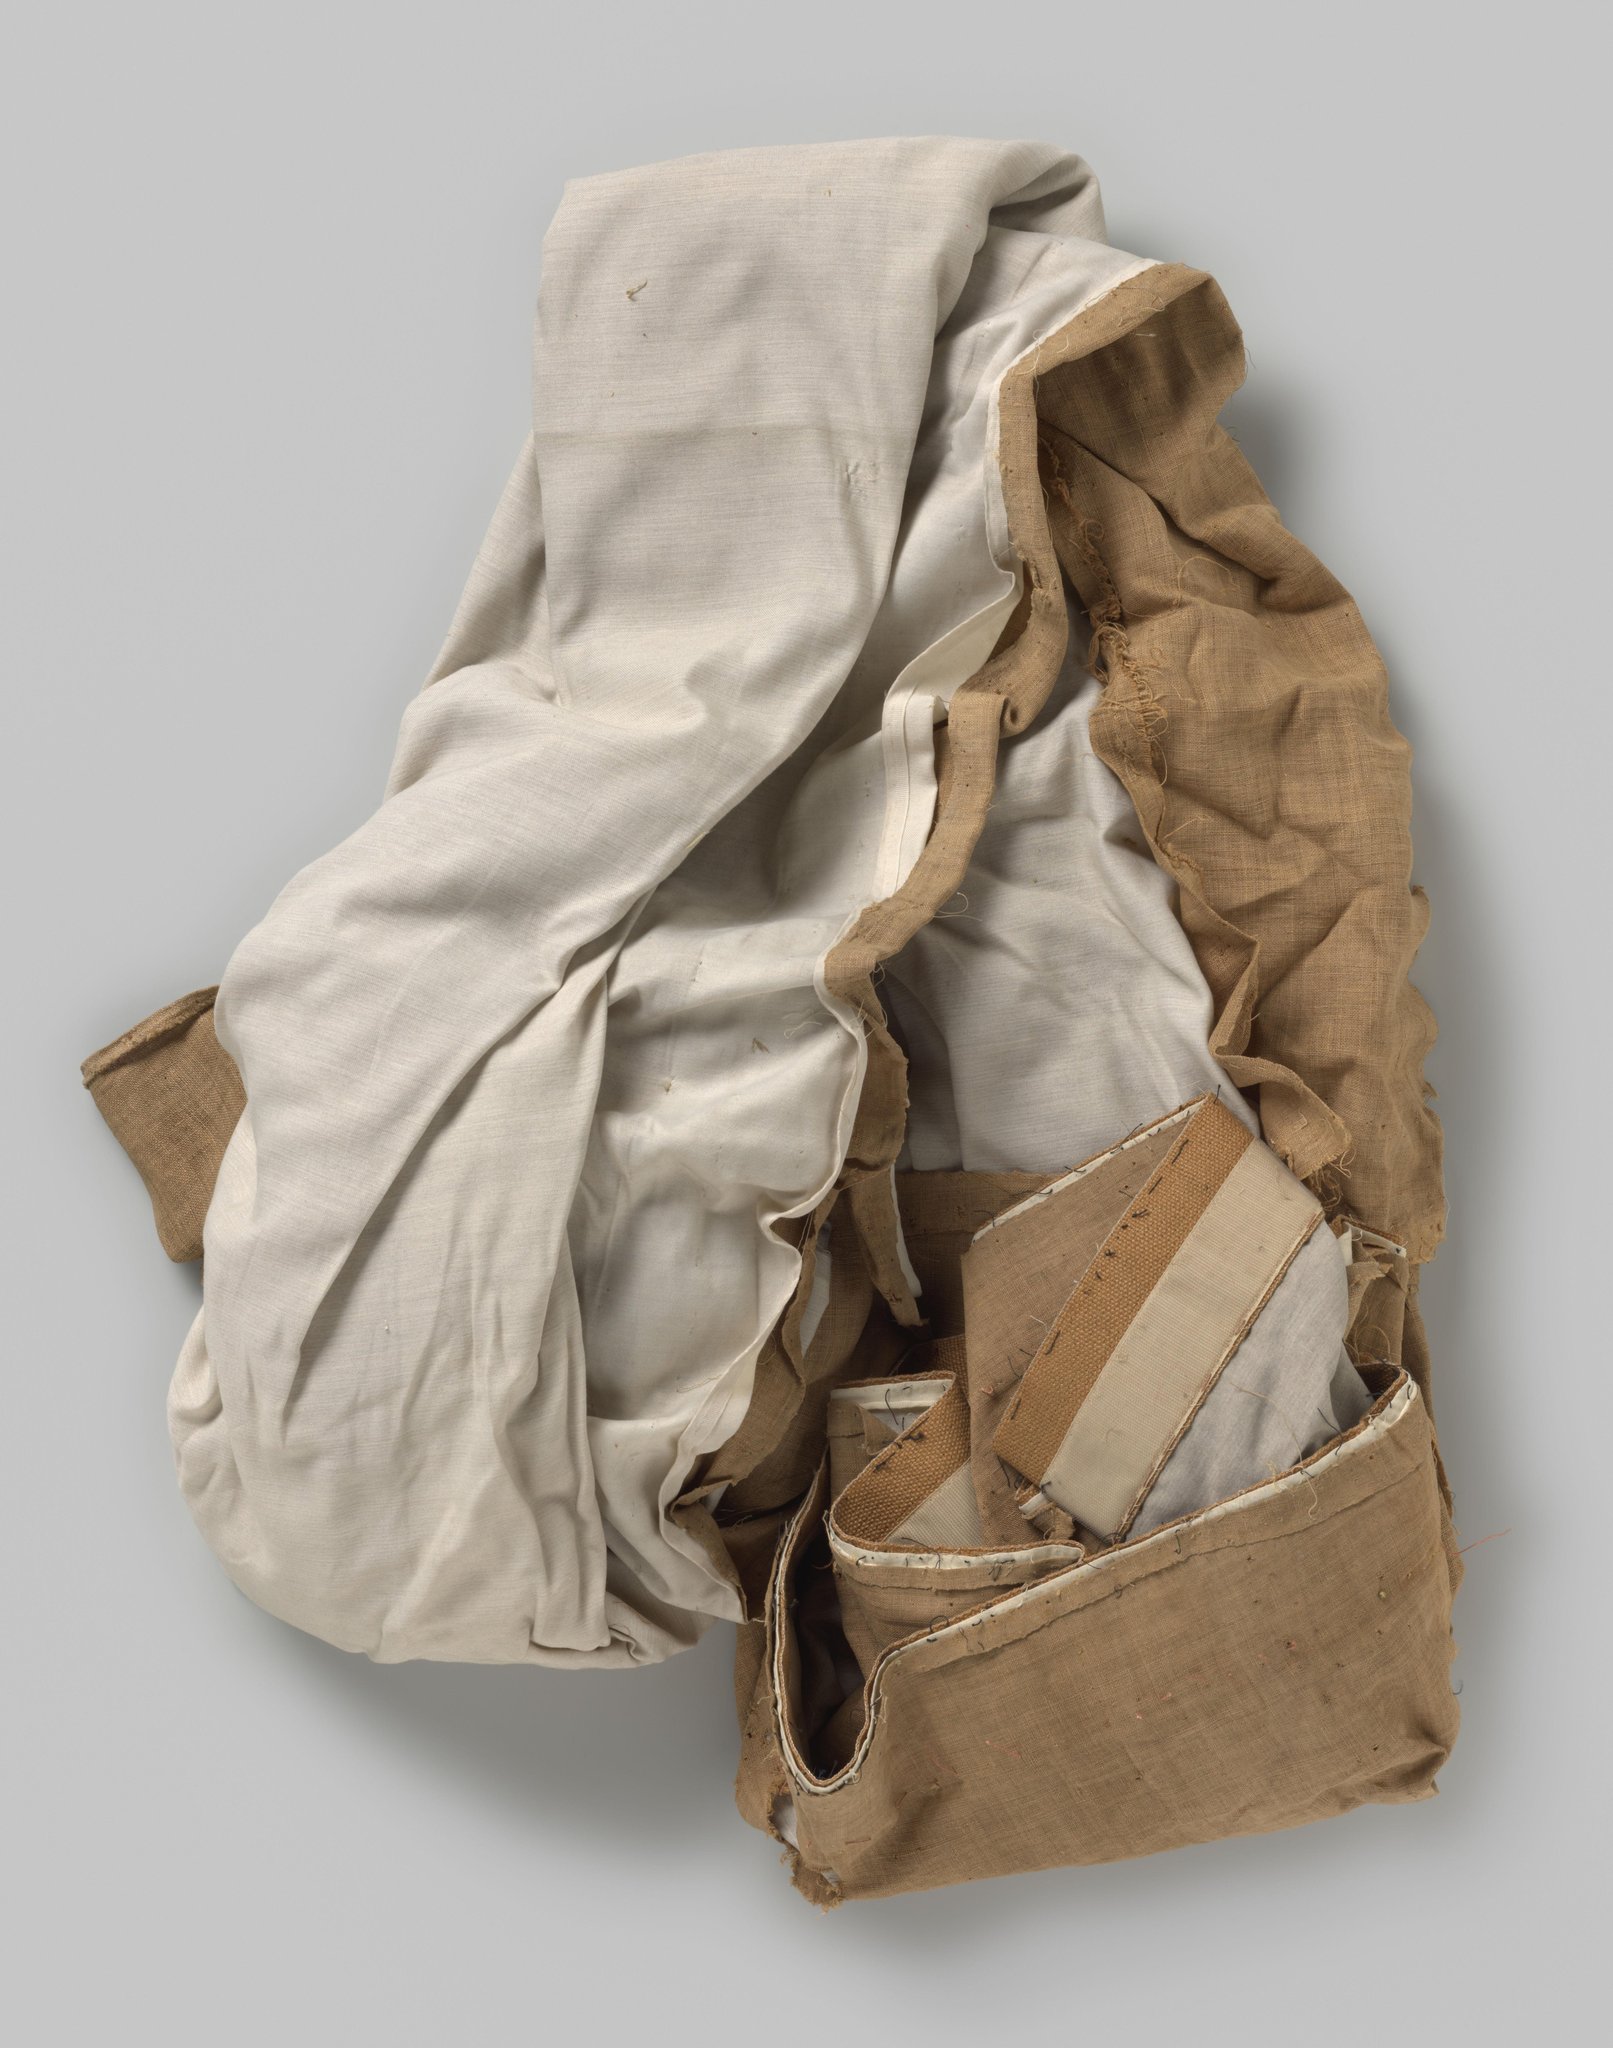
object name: tapestry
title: Voering van wandtapijt met de geschiedenis van Caphalus aan Phocus over zijn hond Lelaps en de wilde vos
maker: françois spiering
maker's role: tapijtwever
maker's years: 1549-1630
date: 1593-1600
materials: cotton, linen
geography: delft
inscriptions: inscription: ‘ULXSSES ET CIRCE’, signature: ‘Franciscvs.Spiringivs.fecit.’, inscription: ‘IVPITER.ET.CALISTO’, town mark: ‘BB’